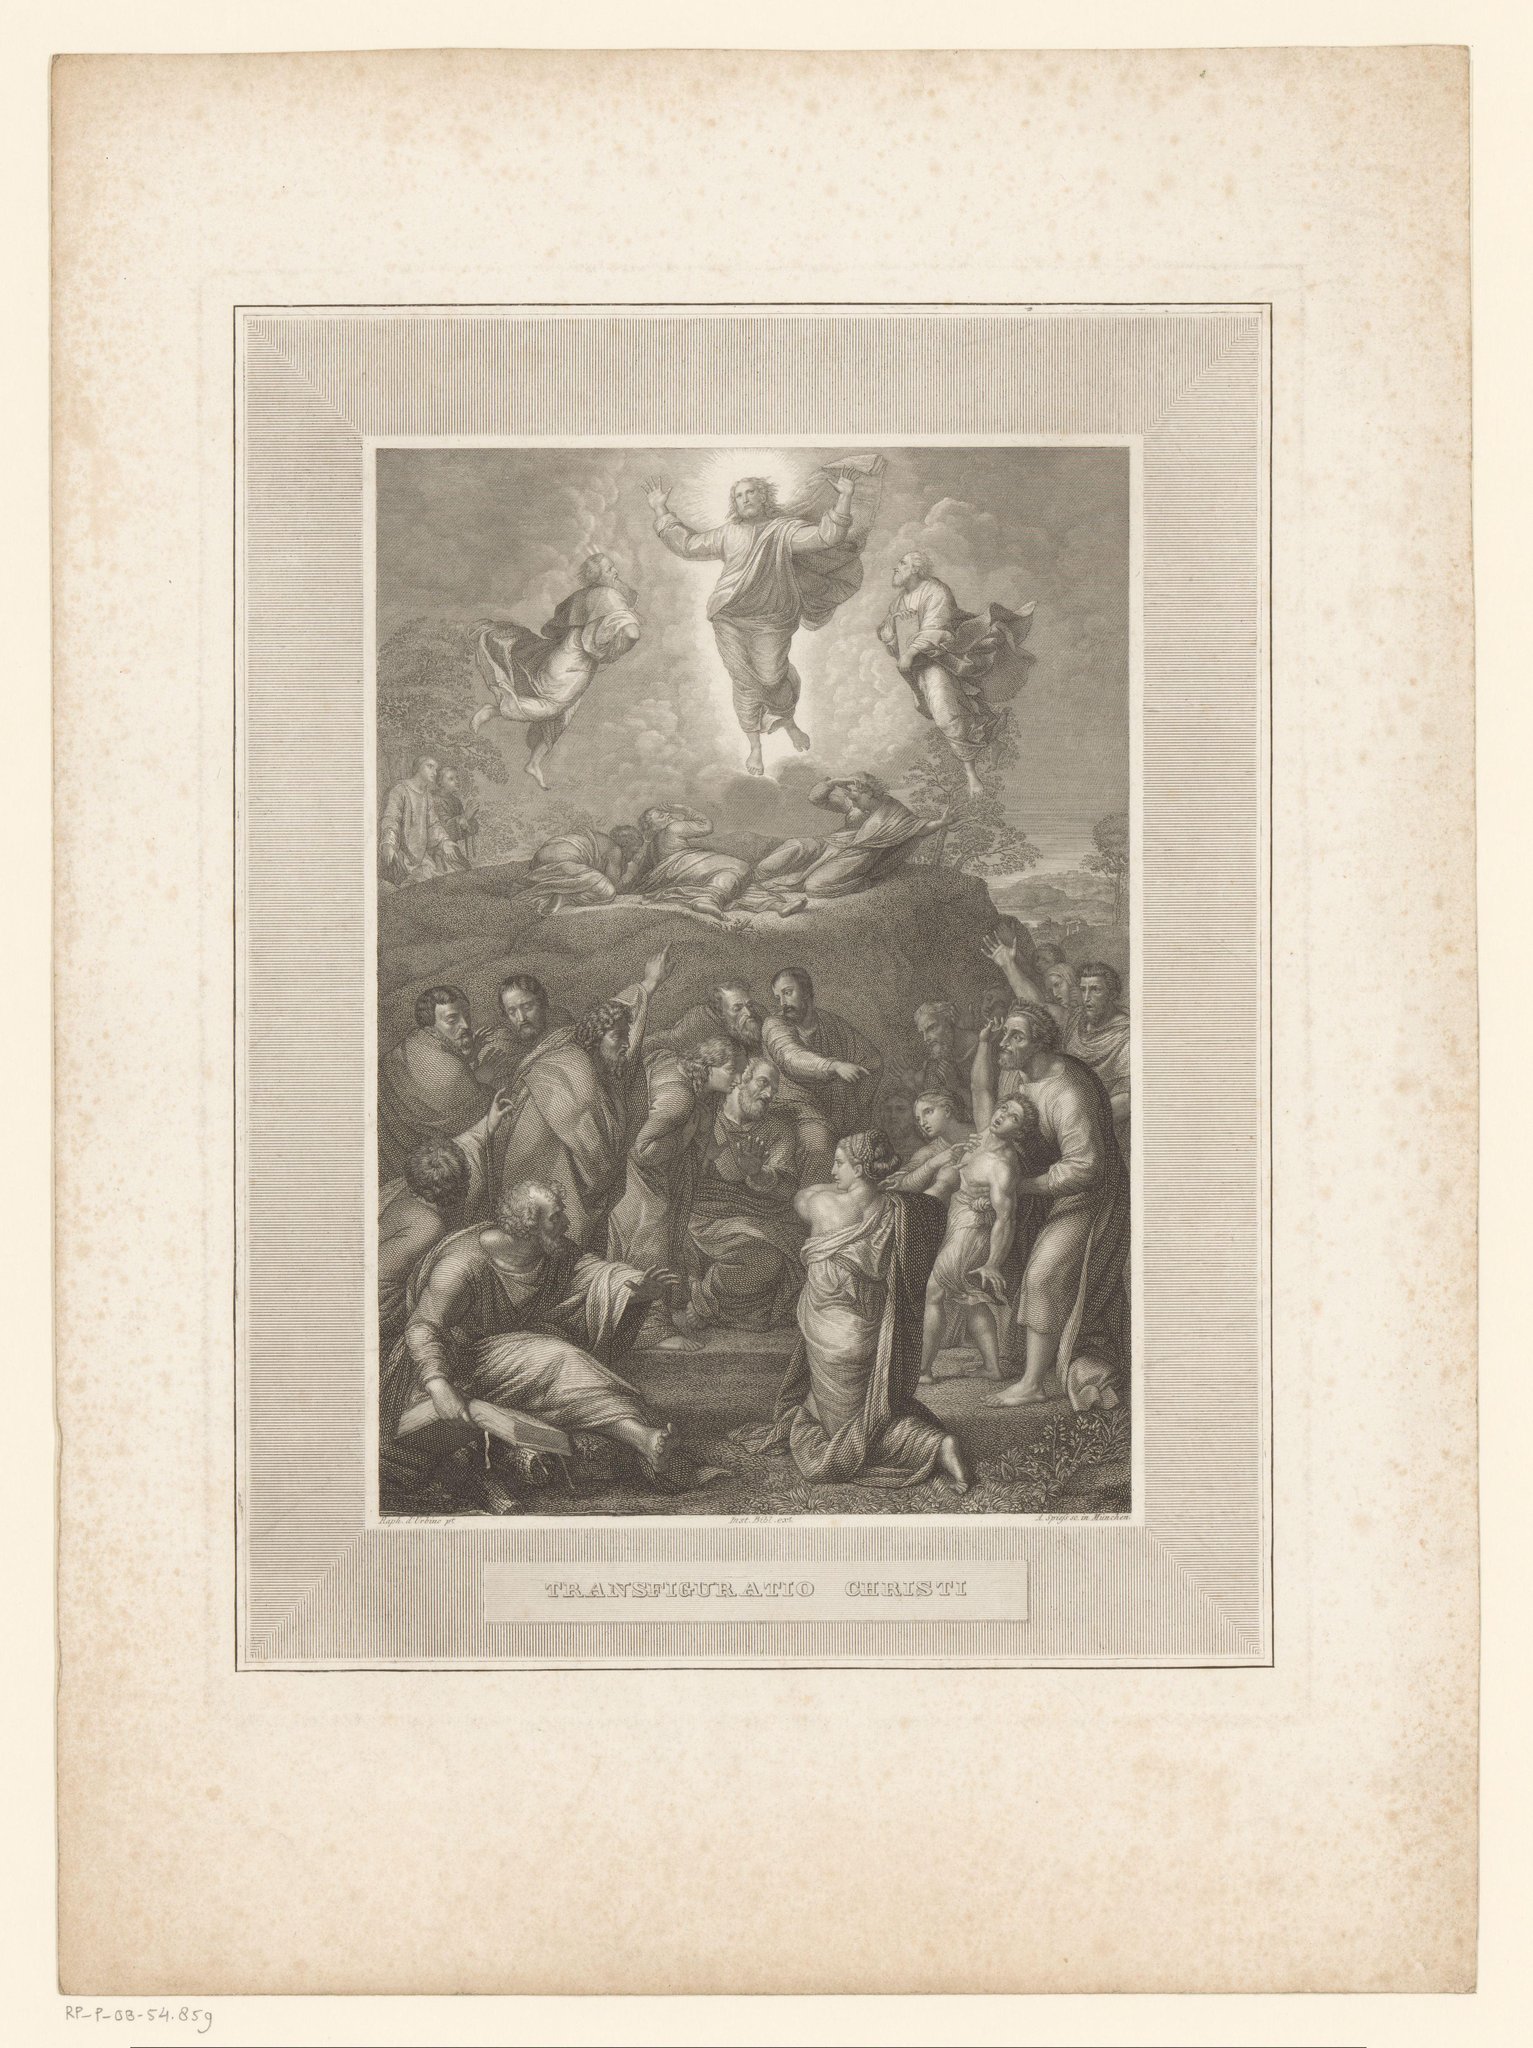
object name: print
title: Transfiguratio Christi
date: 1816-1855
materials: paper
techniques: engraving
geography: munich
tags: the transfiguration: moses and elijah appear on either side of christ on mount tabor (matthew 17:1-13; mark 9:2-13; luke 9:28-36)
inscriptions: collector's mark: Lugt 2228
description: Prent naar het schilderij van Rafaël in de Vaticaanse Pinacotheek.